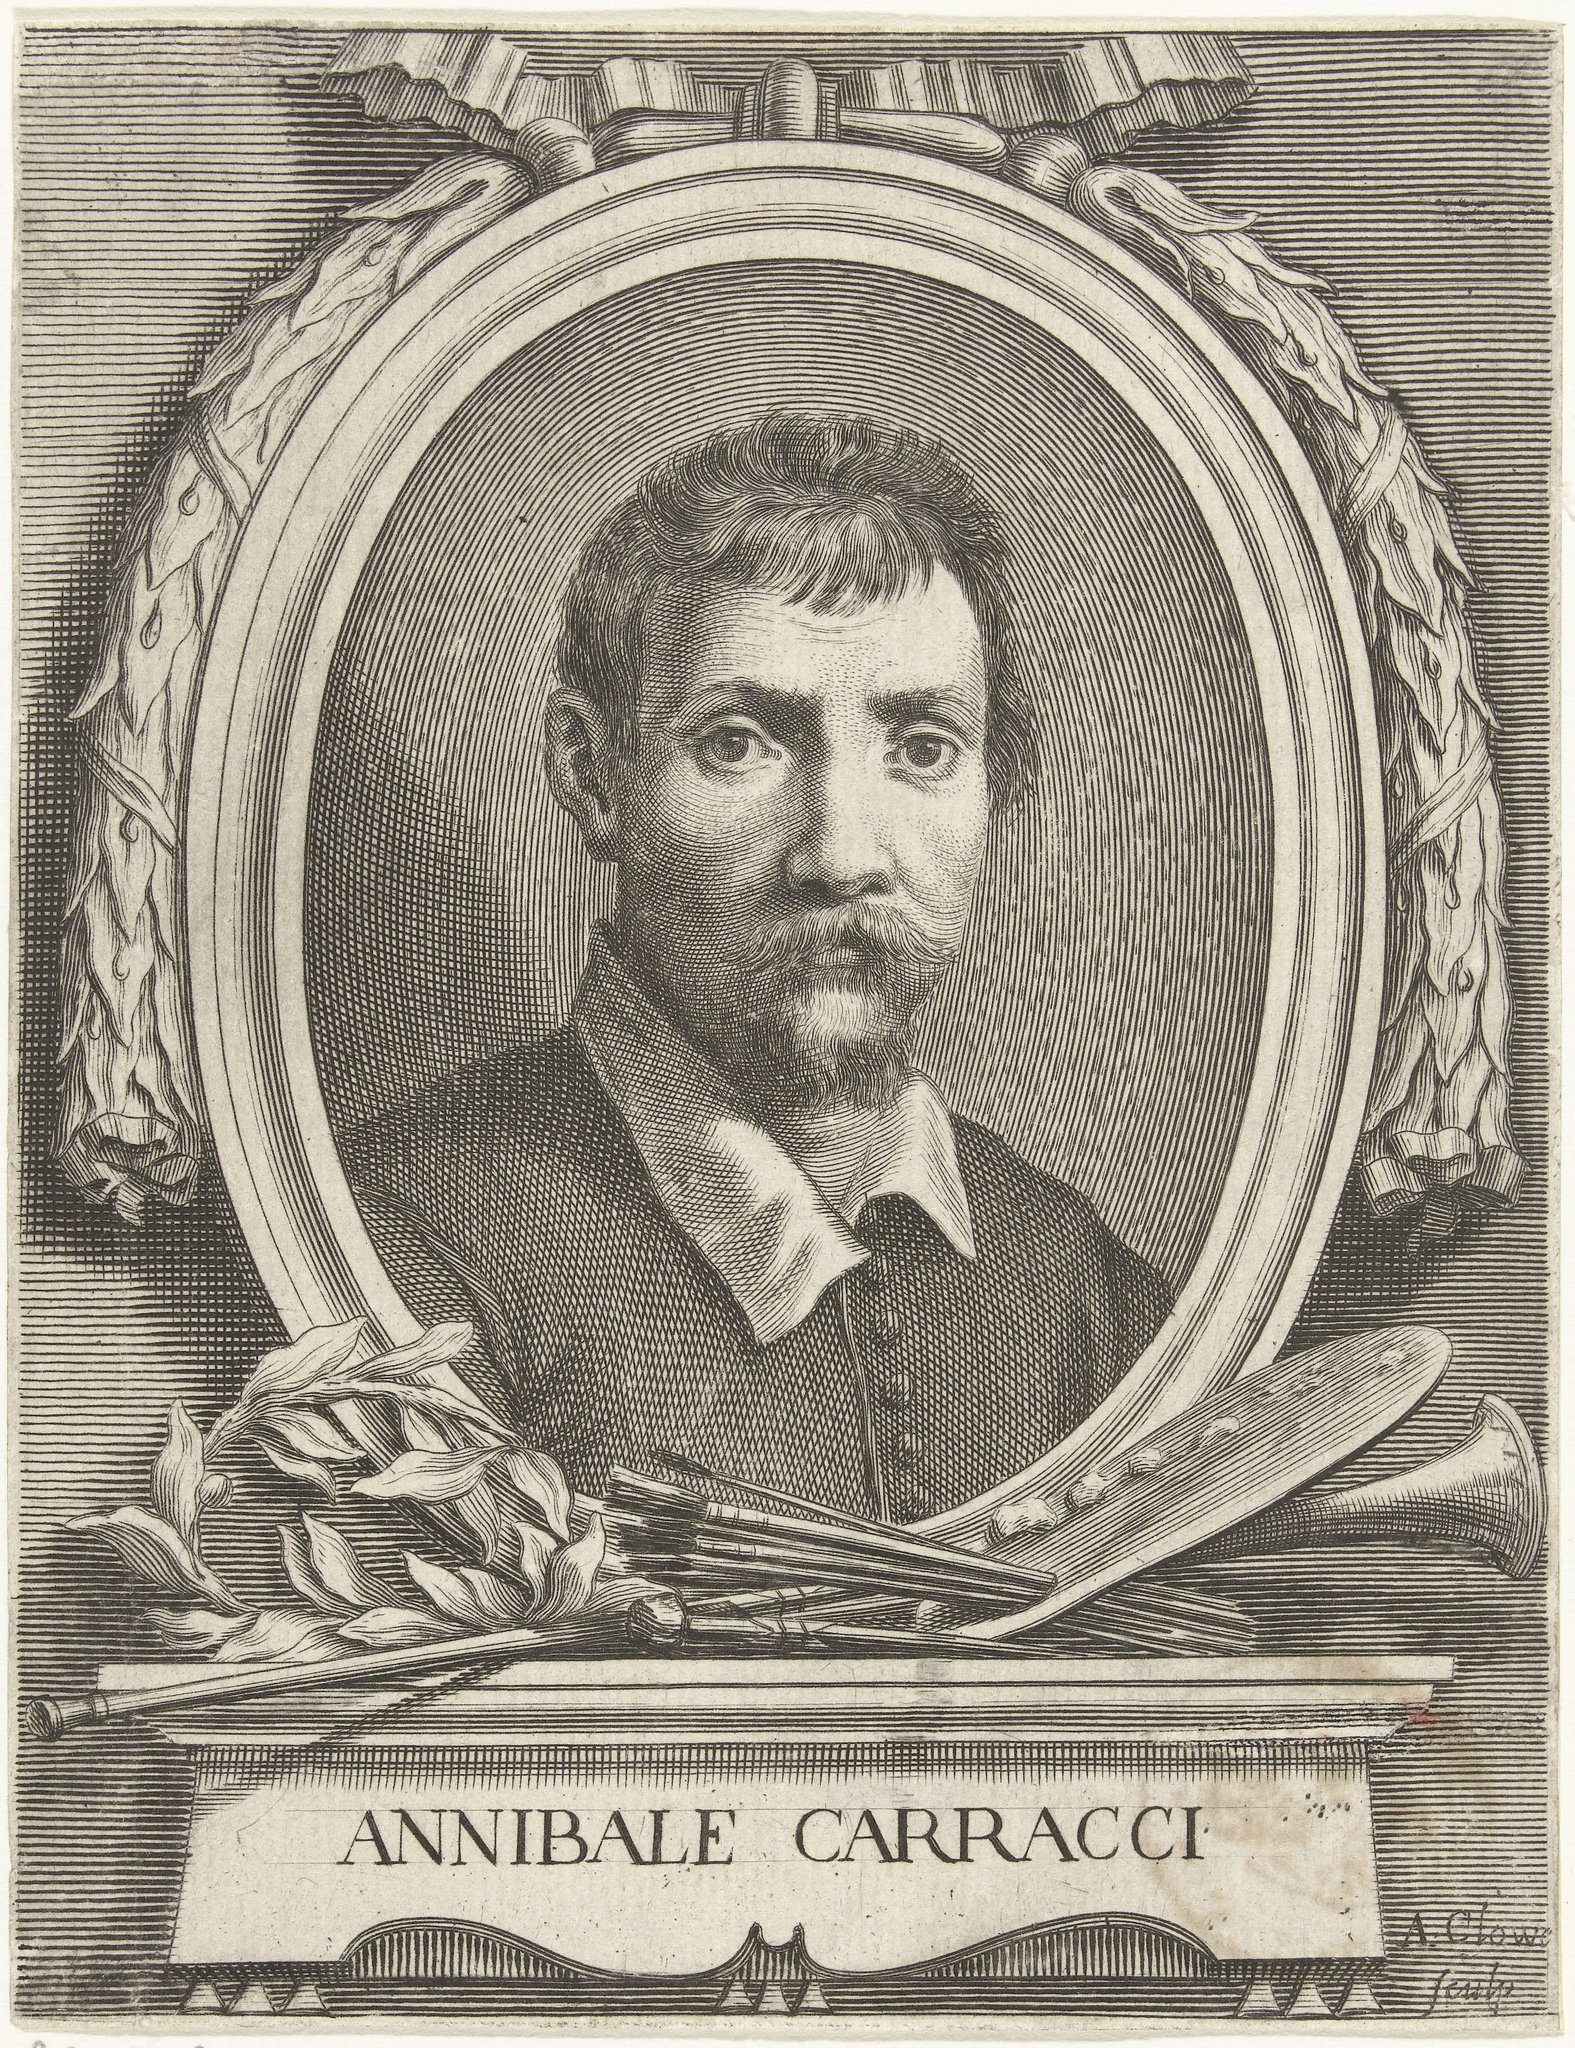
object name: book illustration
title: Portret van Annibale Carracci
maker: albertus clouwet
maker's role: print maker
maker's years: 1636-1679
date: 1672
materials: paper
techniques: engraving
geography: rome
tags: rome, print maker, draughtsman, annibale carracci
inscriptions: collector's mark: Lugt 240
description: illustratie voor: Giovanni Pietro Bellori, "Vite de' pittori, scultori et architetti moderni", Rome, 1672.